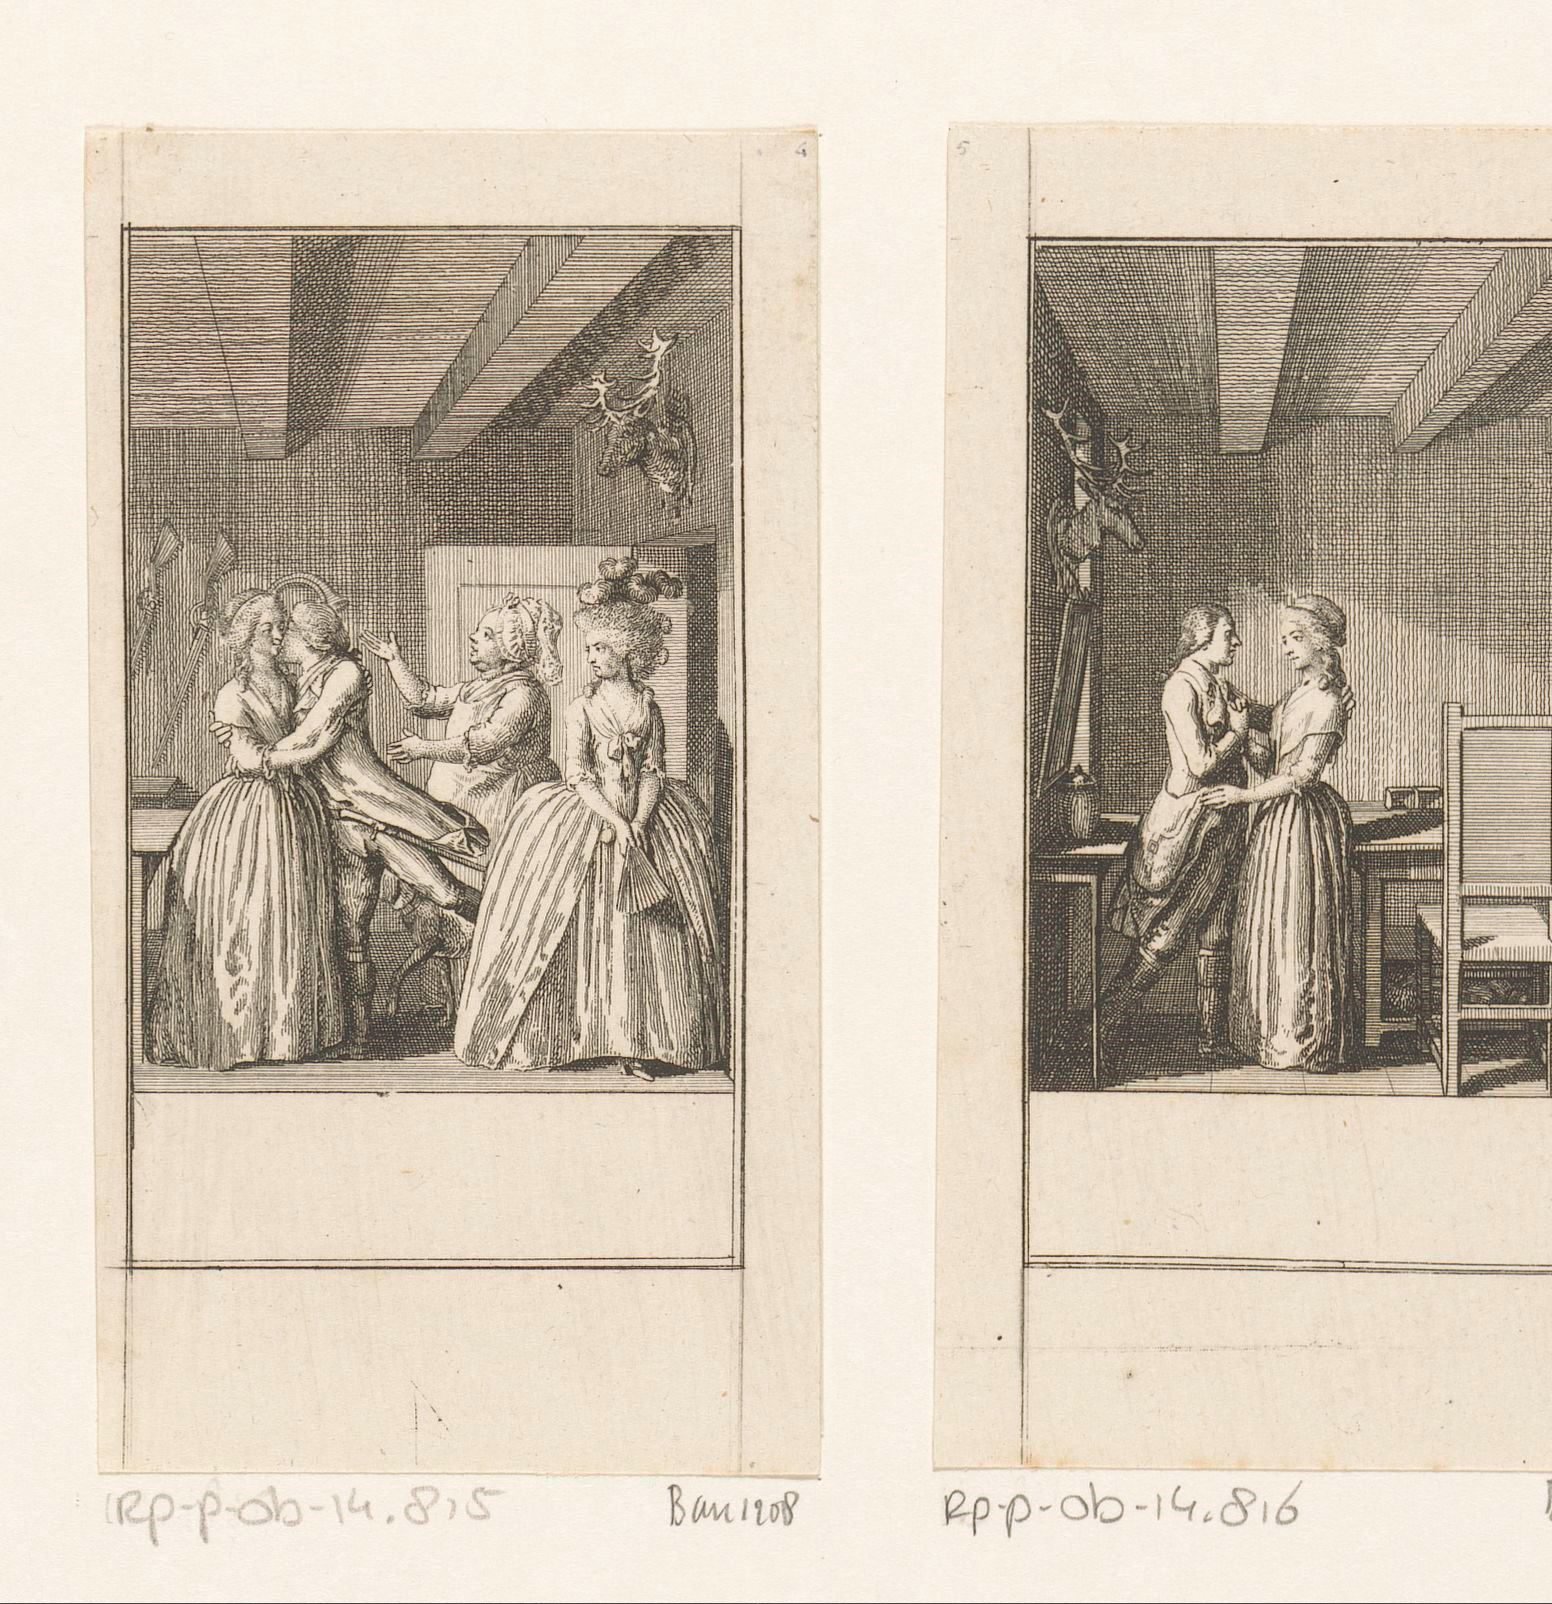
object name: print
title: Anton kust Friederike in plaats van zijn verloofde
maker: daniel nikolaus chodowiecki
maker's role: draughtsman, print maker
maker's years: 1726-1801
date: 1786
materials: paper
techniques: etching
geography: berlin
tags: literature, embracing each other, kissing, jealousy; 'gelosia', 'rammarico del ben'altrui' (ripa)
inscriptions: collector's mark: Lugt 2228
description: Vervaardigd voor August Wilhelm Ifflands 'Die Jäger'. Latere staat gebruikt voor: Berliner genealogischen Calender auf das Jahr 1787. Berlijn: s.n., 1786.